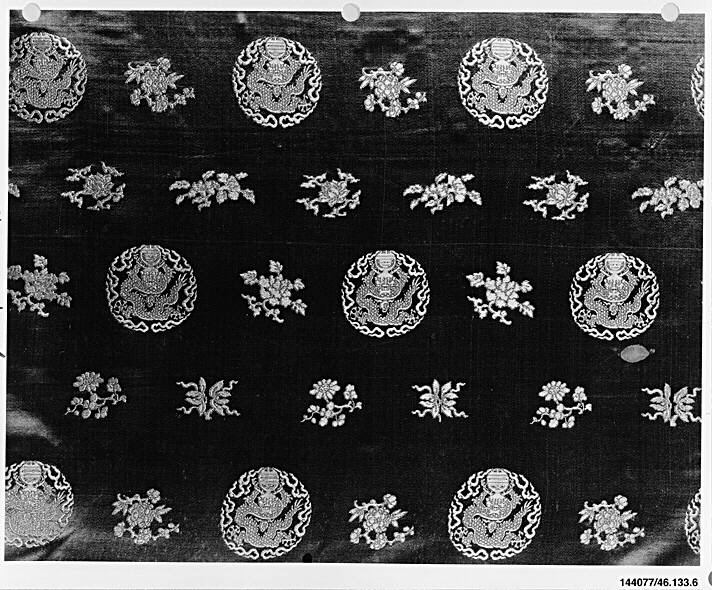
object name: piece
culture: chinese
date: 1701-1800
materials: metal thread, silk